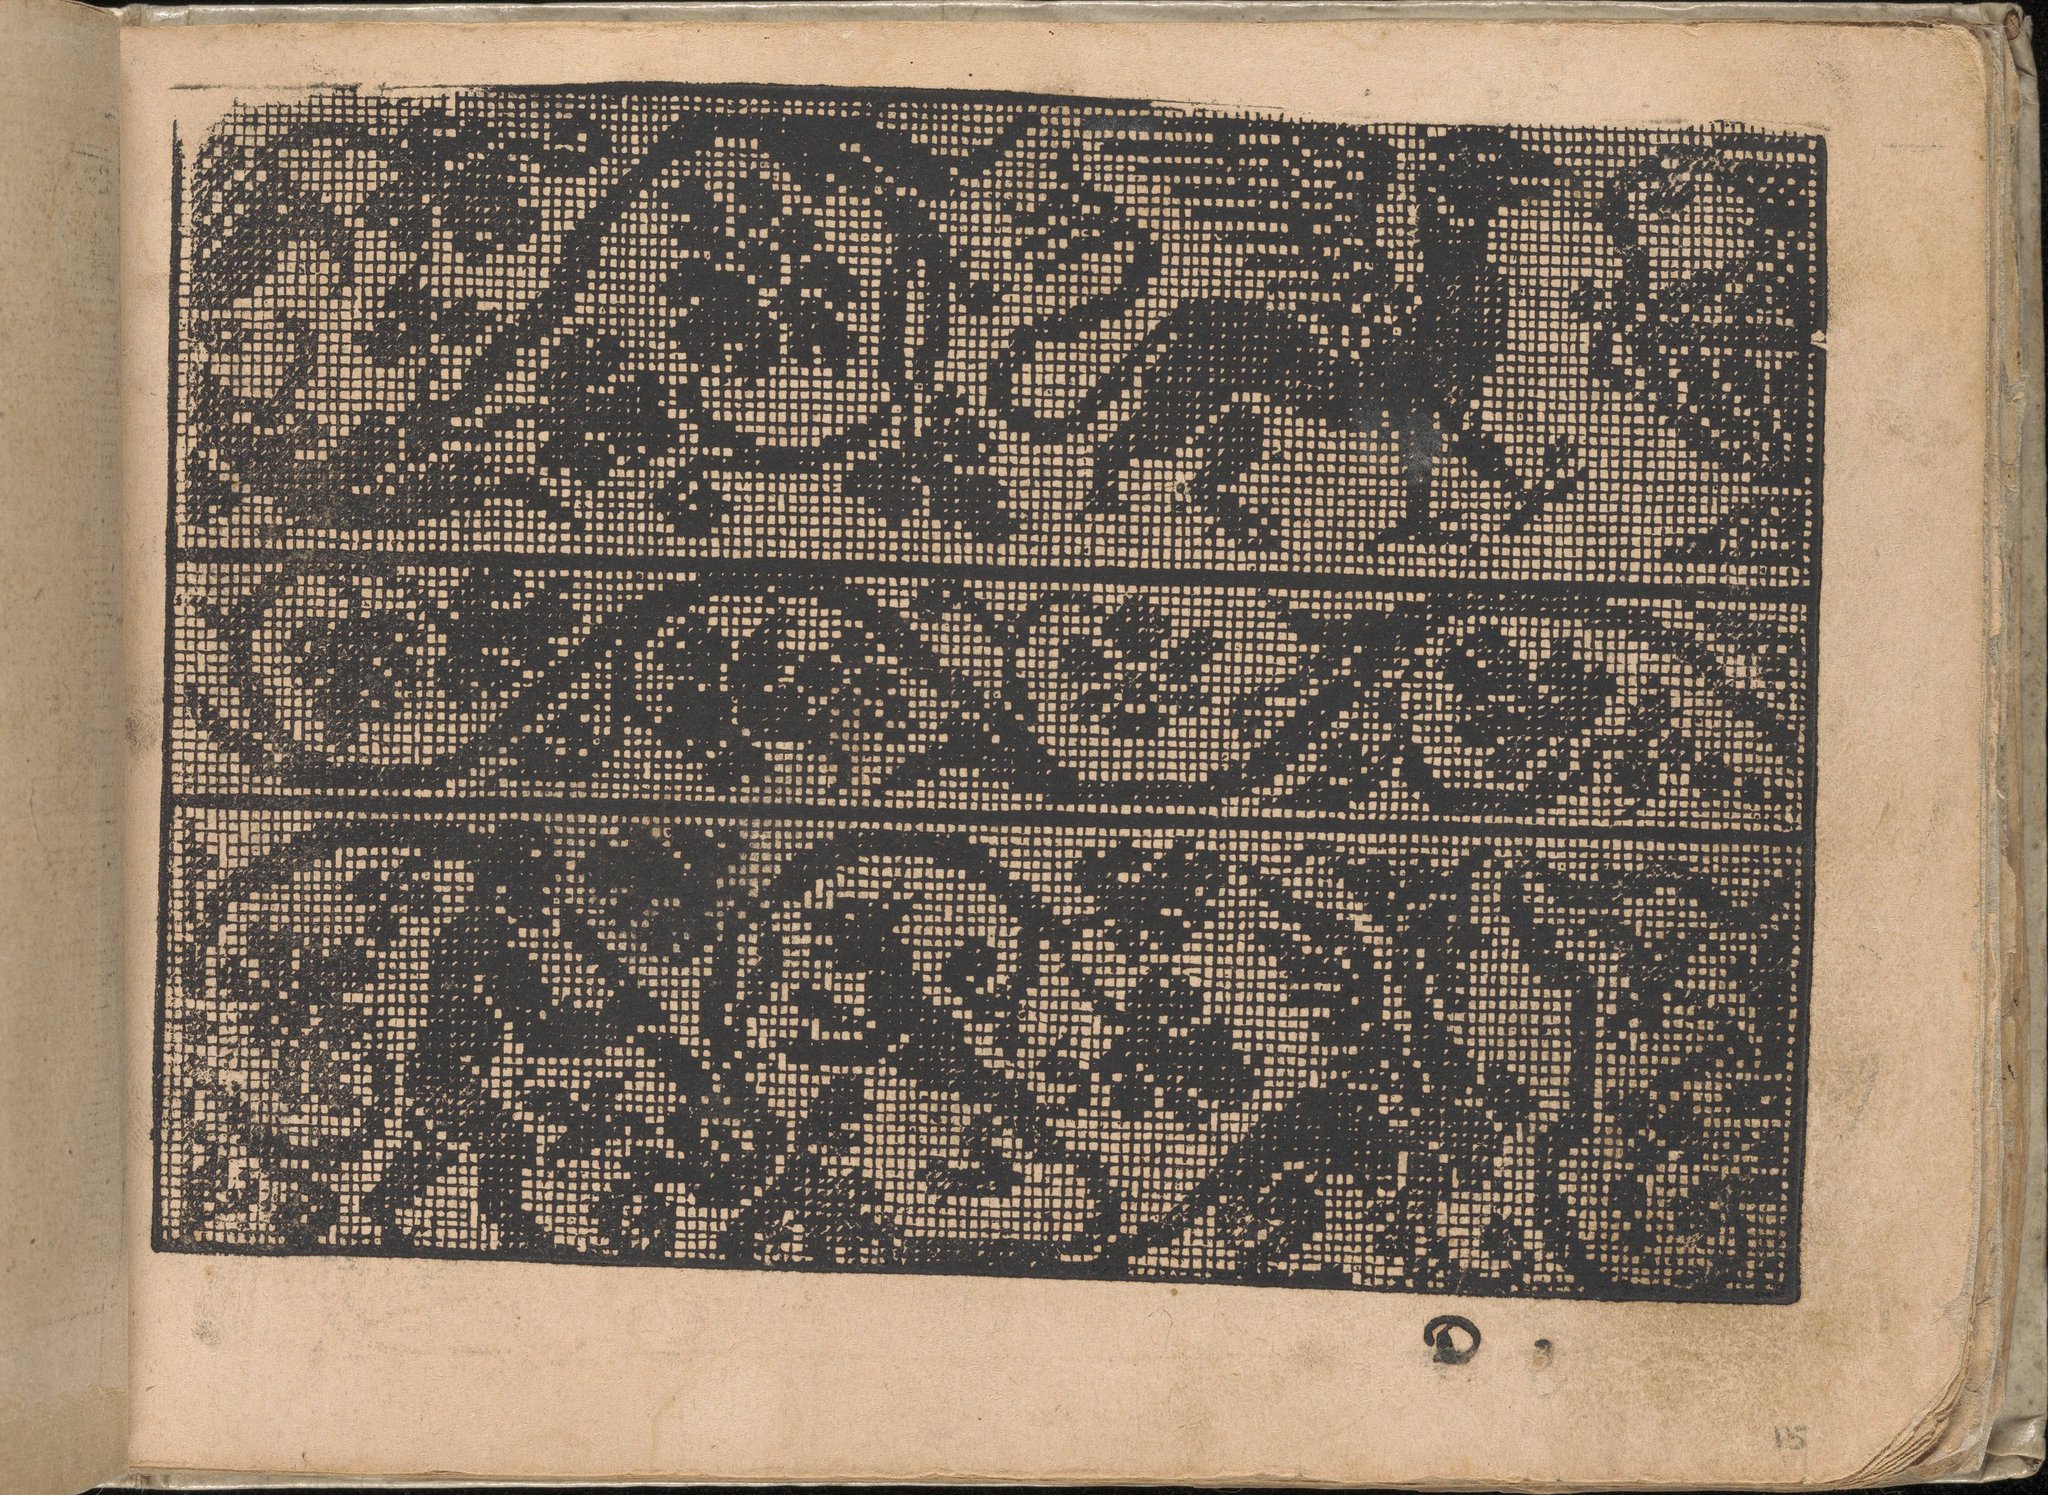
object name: book print ornament architecture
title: Neu künstlich Modelbuch (page 15r)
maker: bernhard jobin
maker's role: publisher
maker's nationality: swiss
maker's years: 1535-1597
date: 1598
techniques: woodcut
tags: griffins